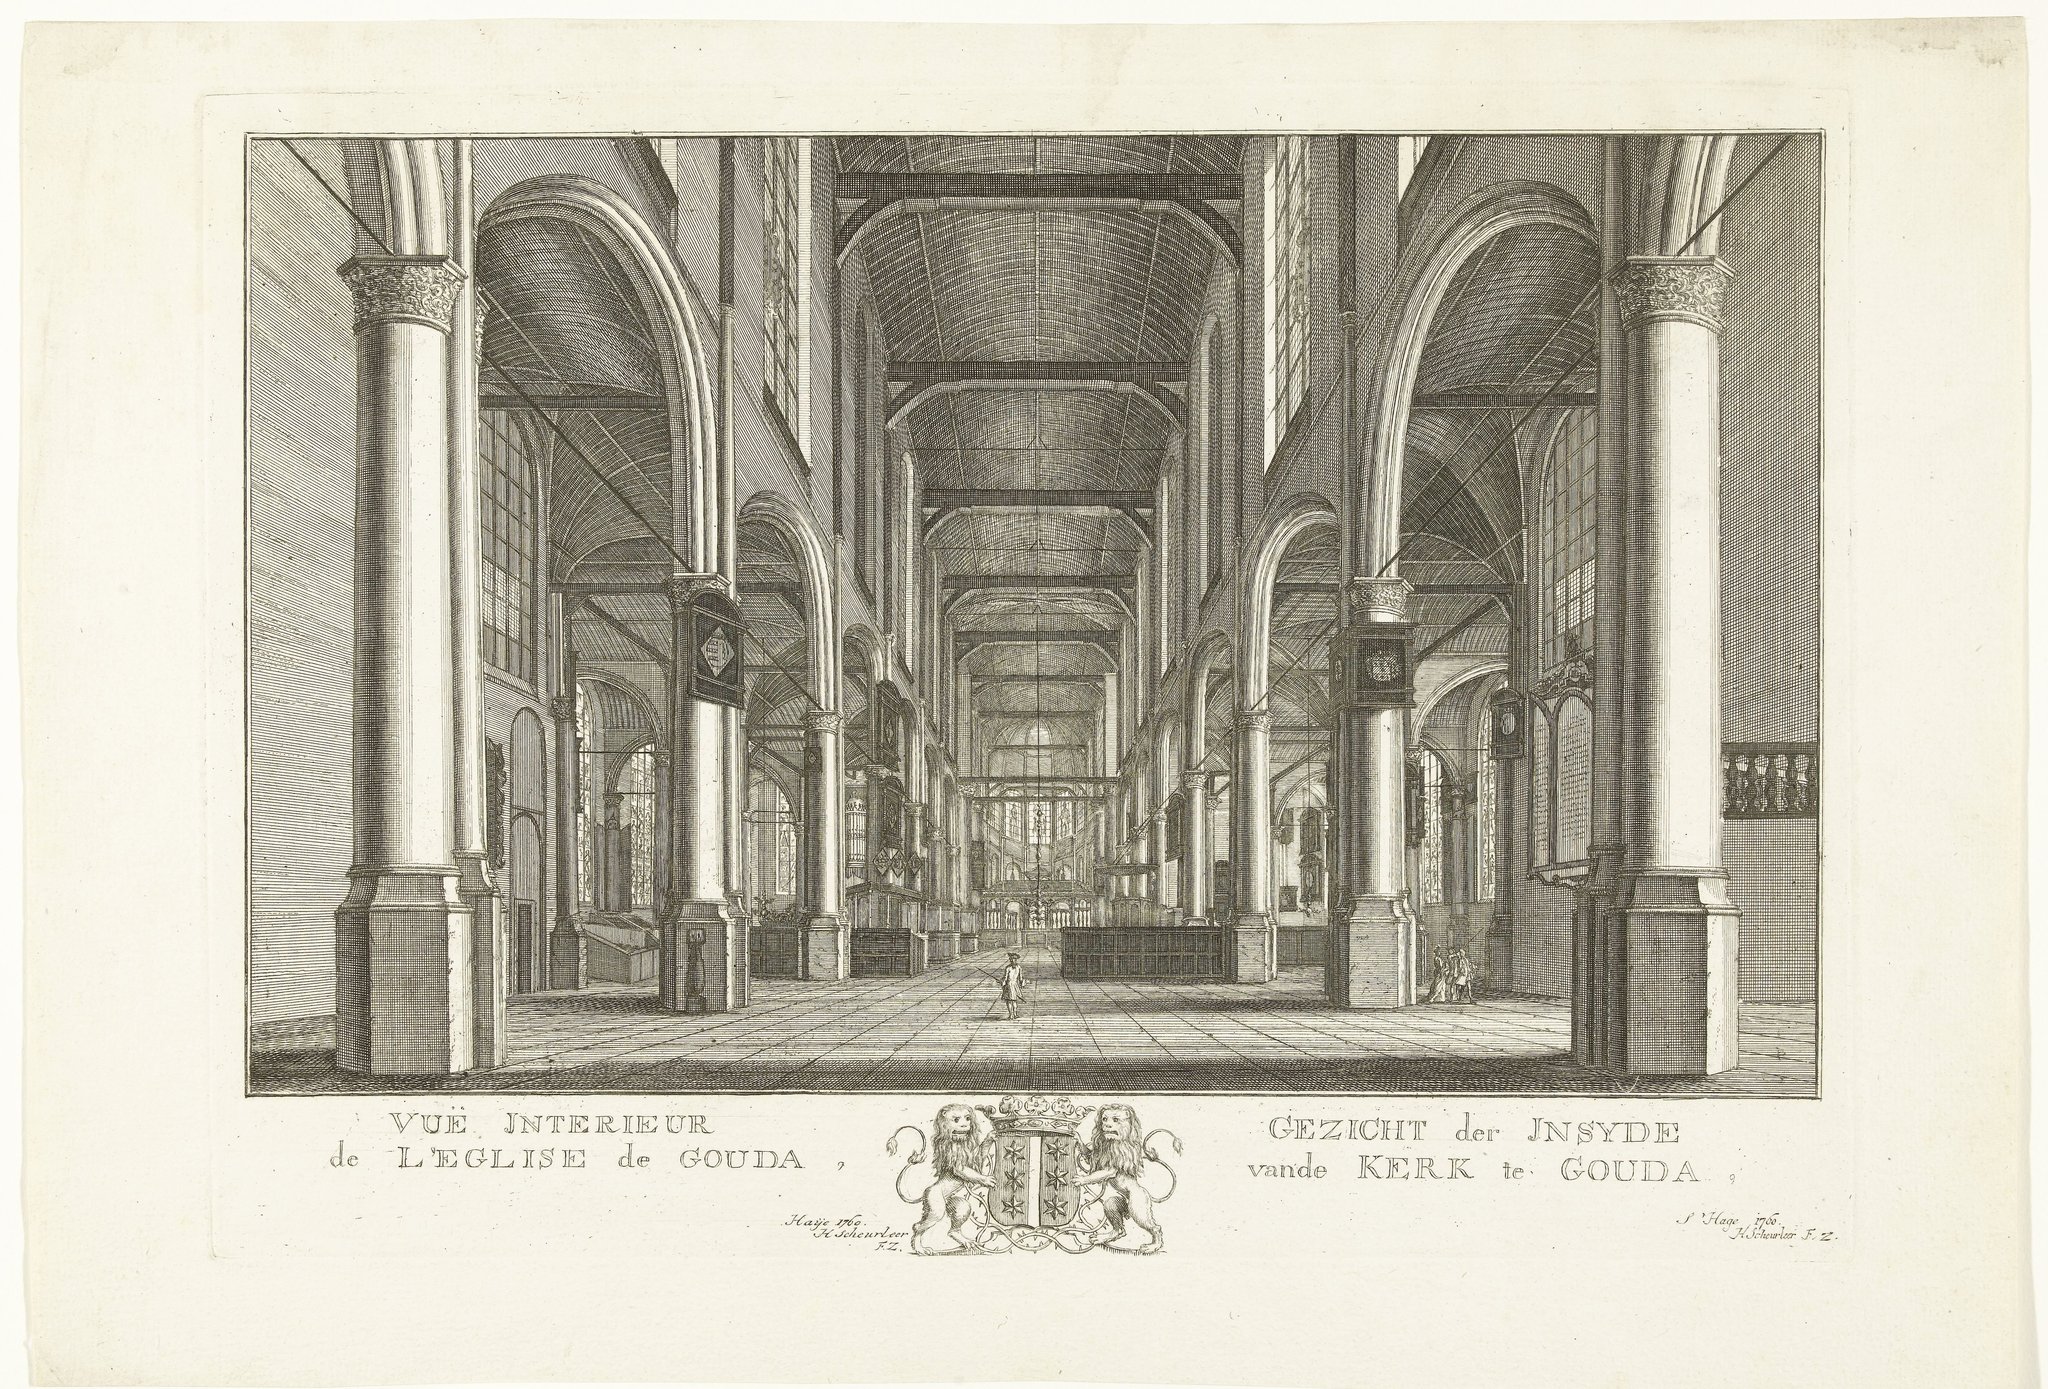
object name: print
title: Interieur van de Sint-Janskerk te Gouda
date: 1760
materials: paper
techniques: engraving, etching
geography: the hague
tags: interior of church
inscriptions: collector's mark: Lugt 2228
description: Het interieur van de Sint-Janskerk te Gouda. In de kerk staan enkele figuren.